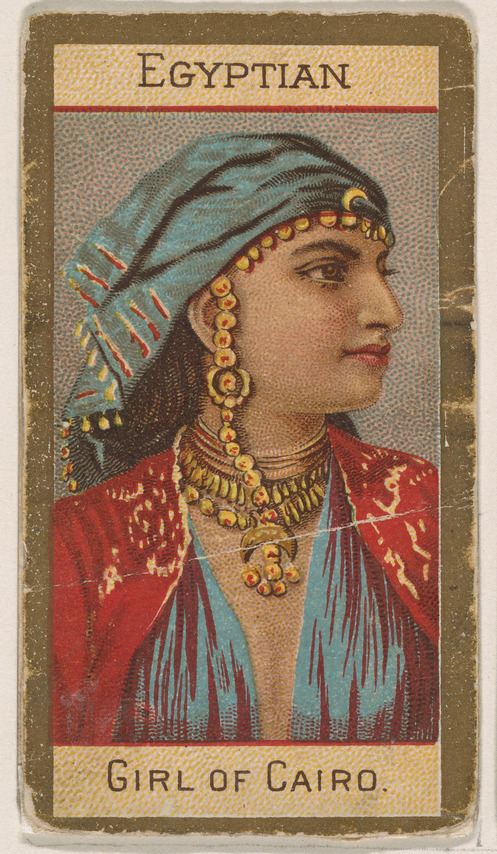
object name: print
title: Egyptian, Girl of Cairo, from Types of Nationalities (N240) issued by Kinney Bros.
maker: kinney brothers tobacco company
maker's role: publisher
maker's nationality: american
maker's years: 1869-2011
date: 1890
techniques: color lithograph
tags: profiles,women